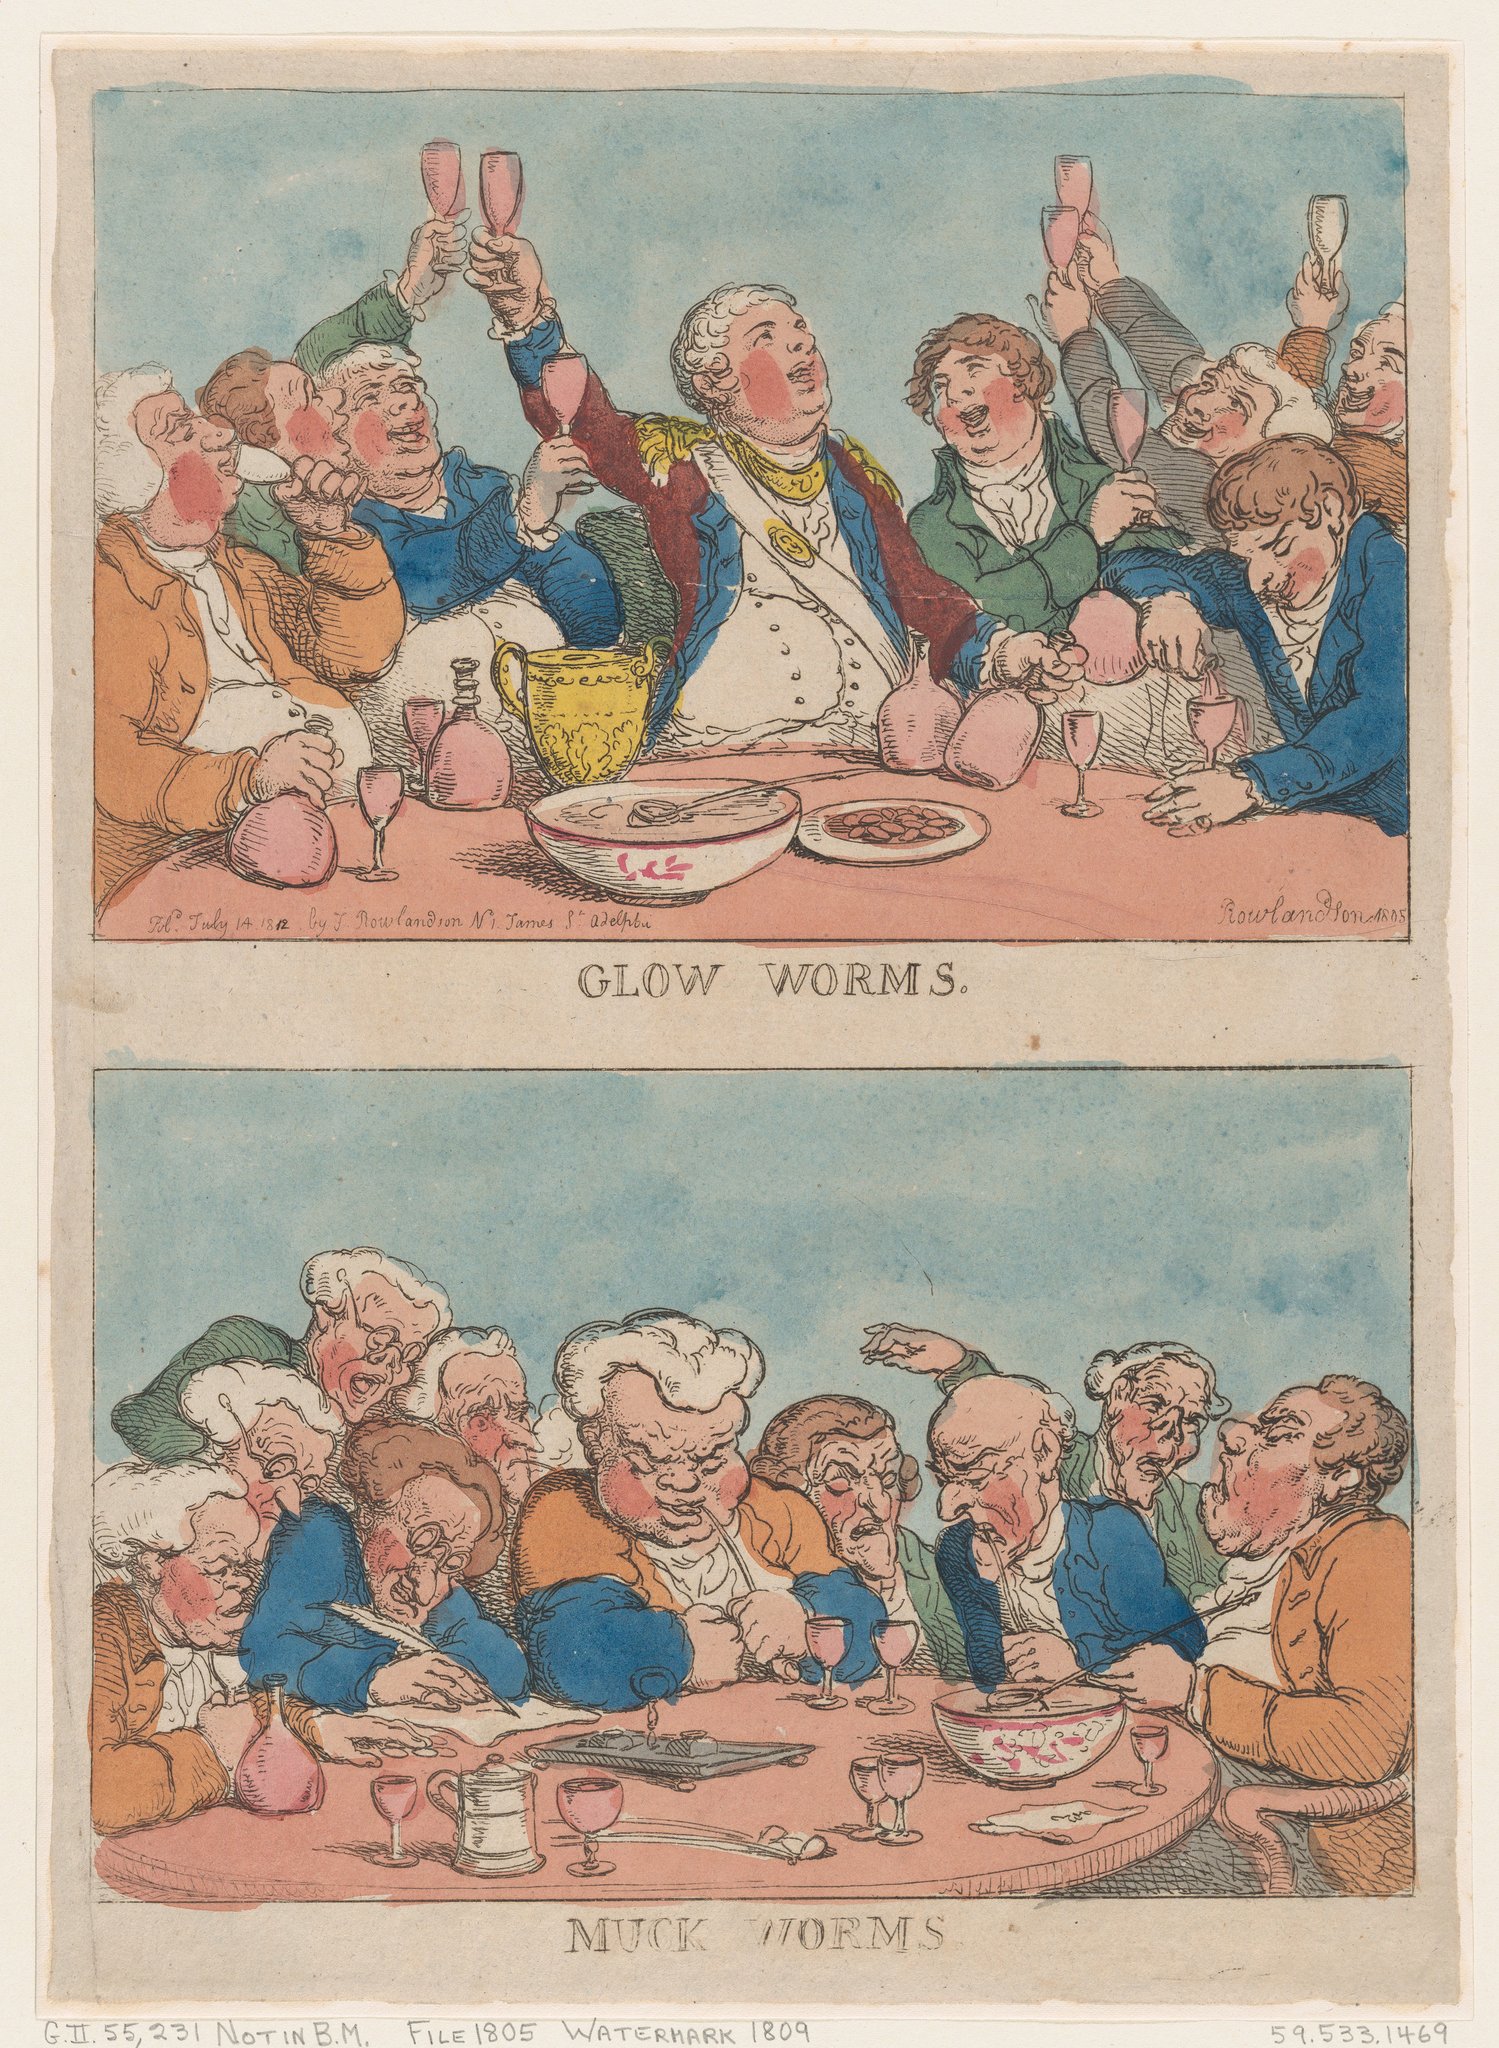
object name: print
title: Glow Worms, Muck Worms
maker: thomas rowlandson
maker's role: artist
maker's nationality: british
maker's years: 1757-1827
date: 1812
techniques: etching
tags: food,satire,men,dining